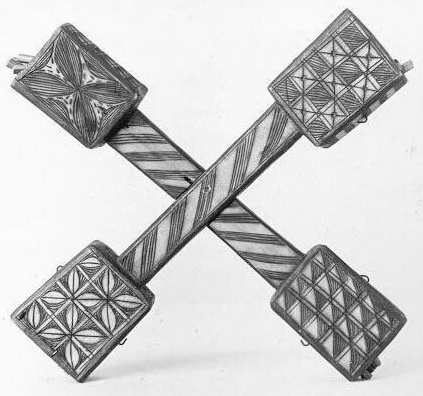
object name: quadruple bell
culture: gabonese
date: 1867-1900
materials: wood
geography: gabon